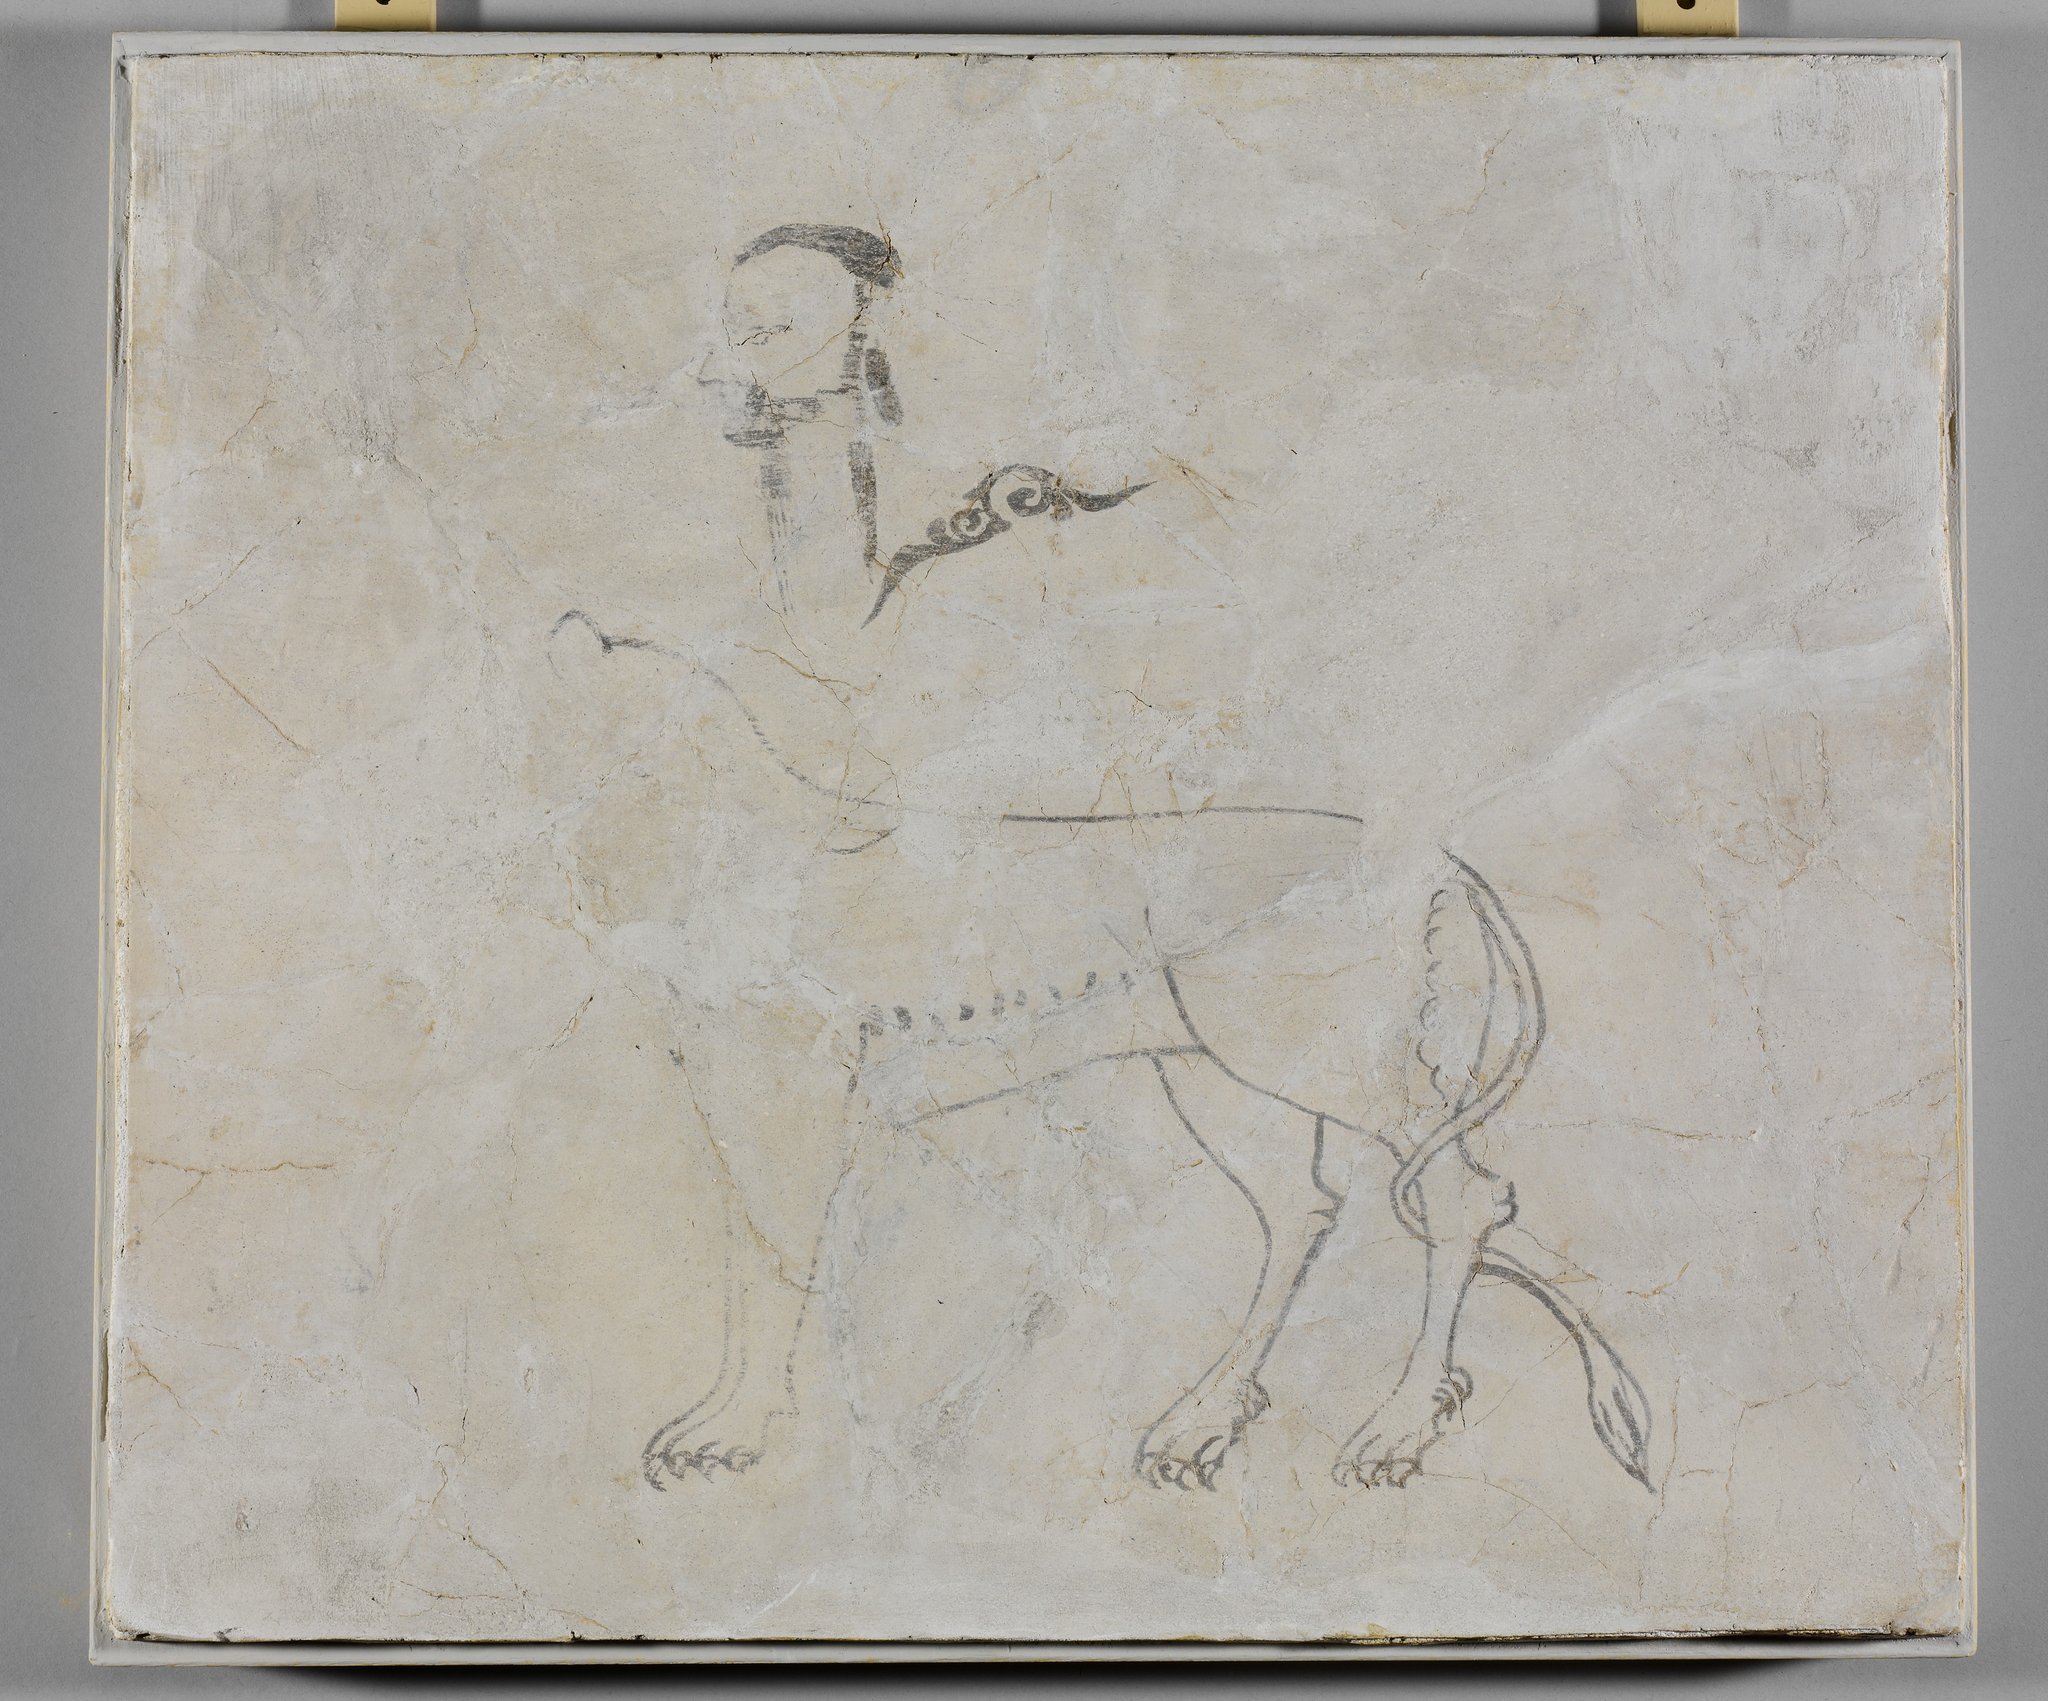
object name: wall painting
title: Panel with Sketches of a Man, a Lion and an Arabesque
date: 801-900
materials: plaster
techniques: painting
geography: iran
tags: men,lions